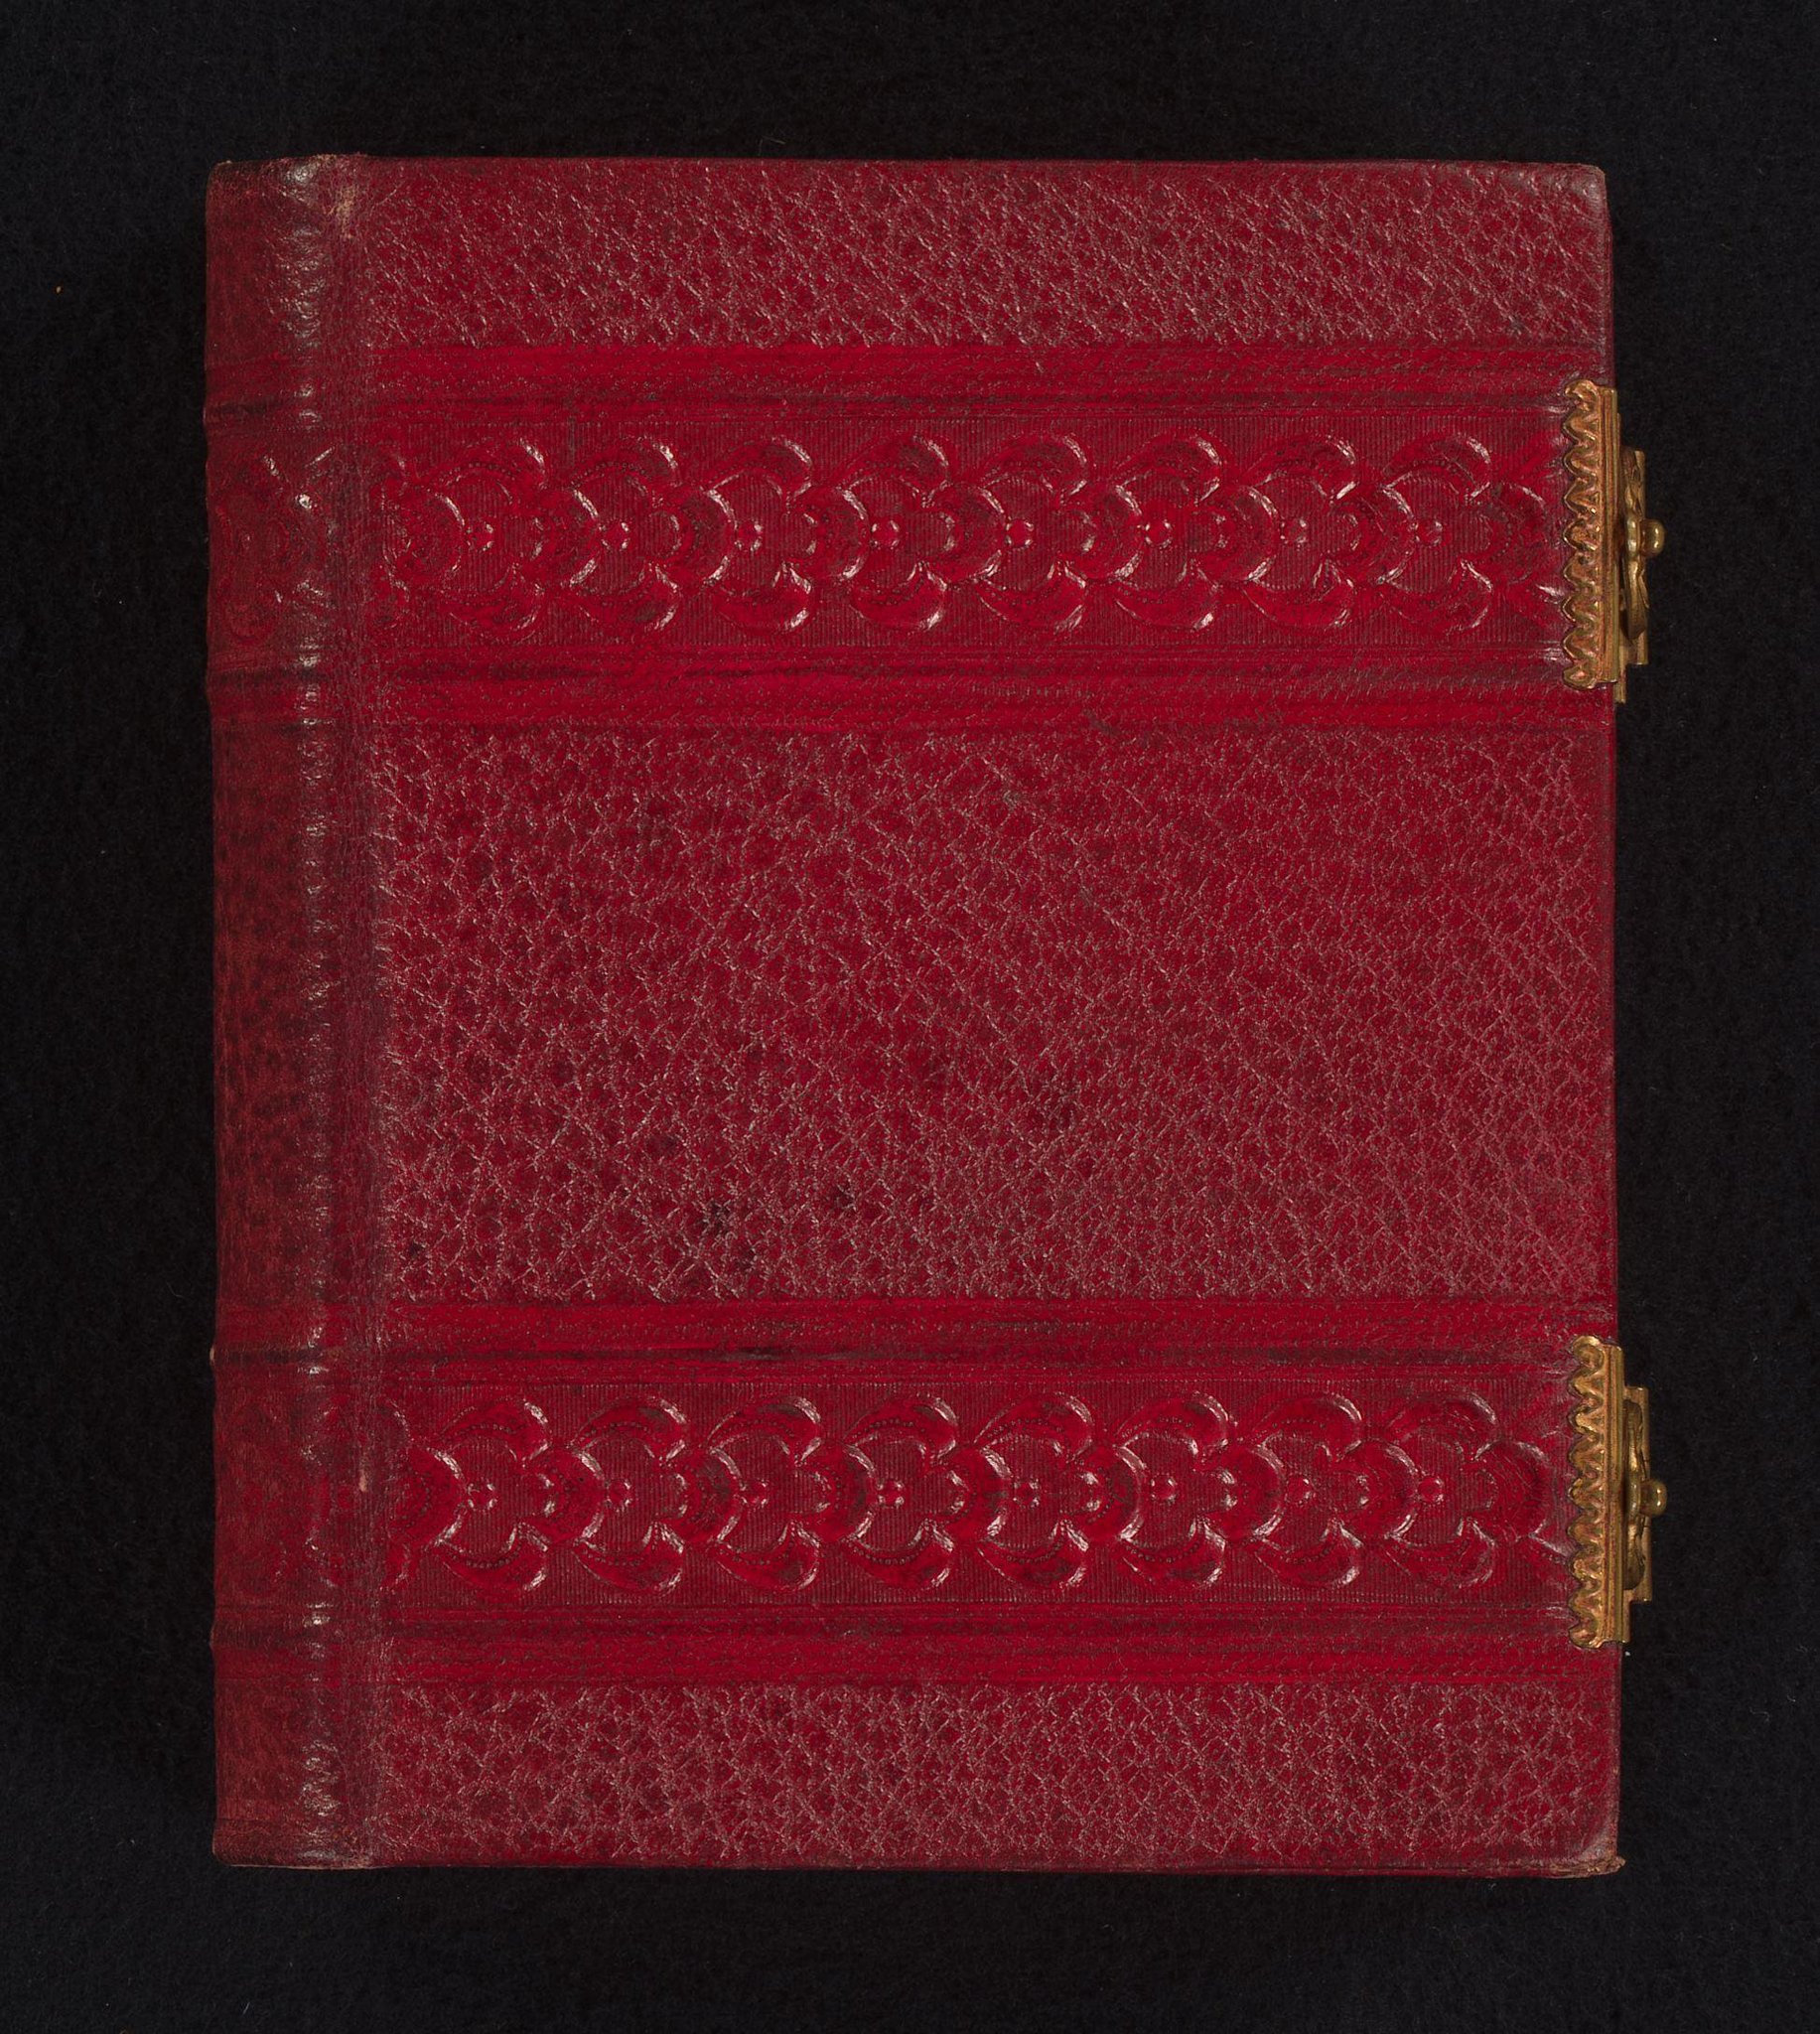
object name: slip in album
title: Fotoalbum (leeg)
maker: Anonymous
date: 1860-1900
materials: cardboard, leather, metal, paper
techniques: marbled paper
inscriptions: collector's mark: ‘DIENST/ VERSPREIDE/ RIJKSKOLLEKTIES/ (...) A 770’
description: Fotoalbum met twintig bladen met aan de voorzijde van ieder blad een met rode lijnen omkaderde passe-partout voor een carte-de-visite.